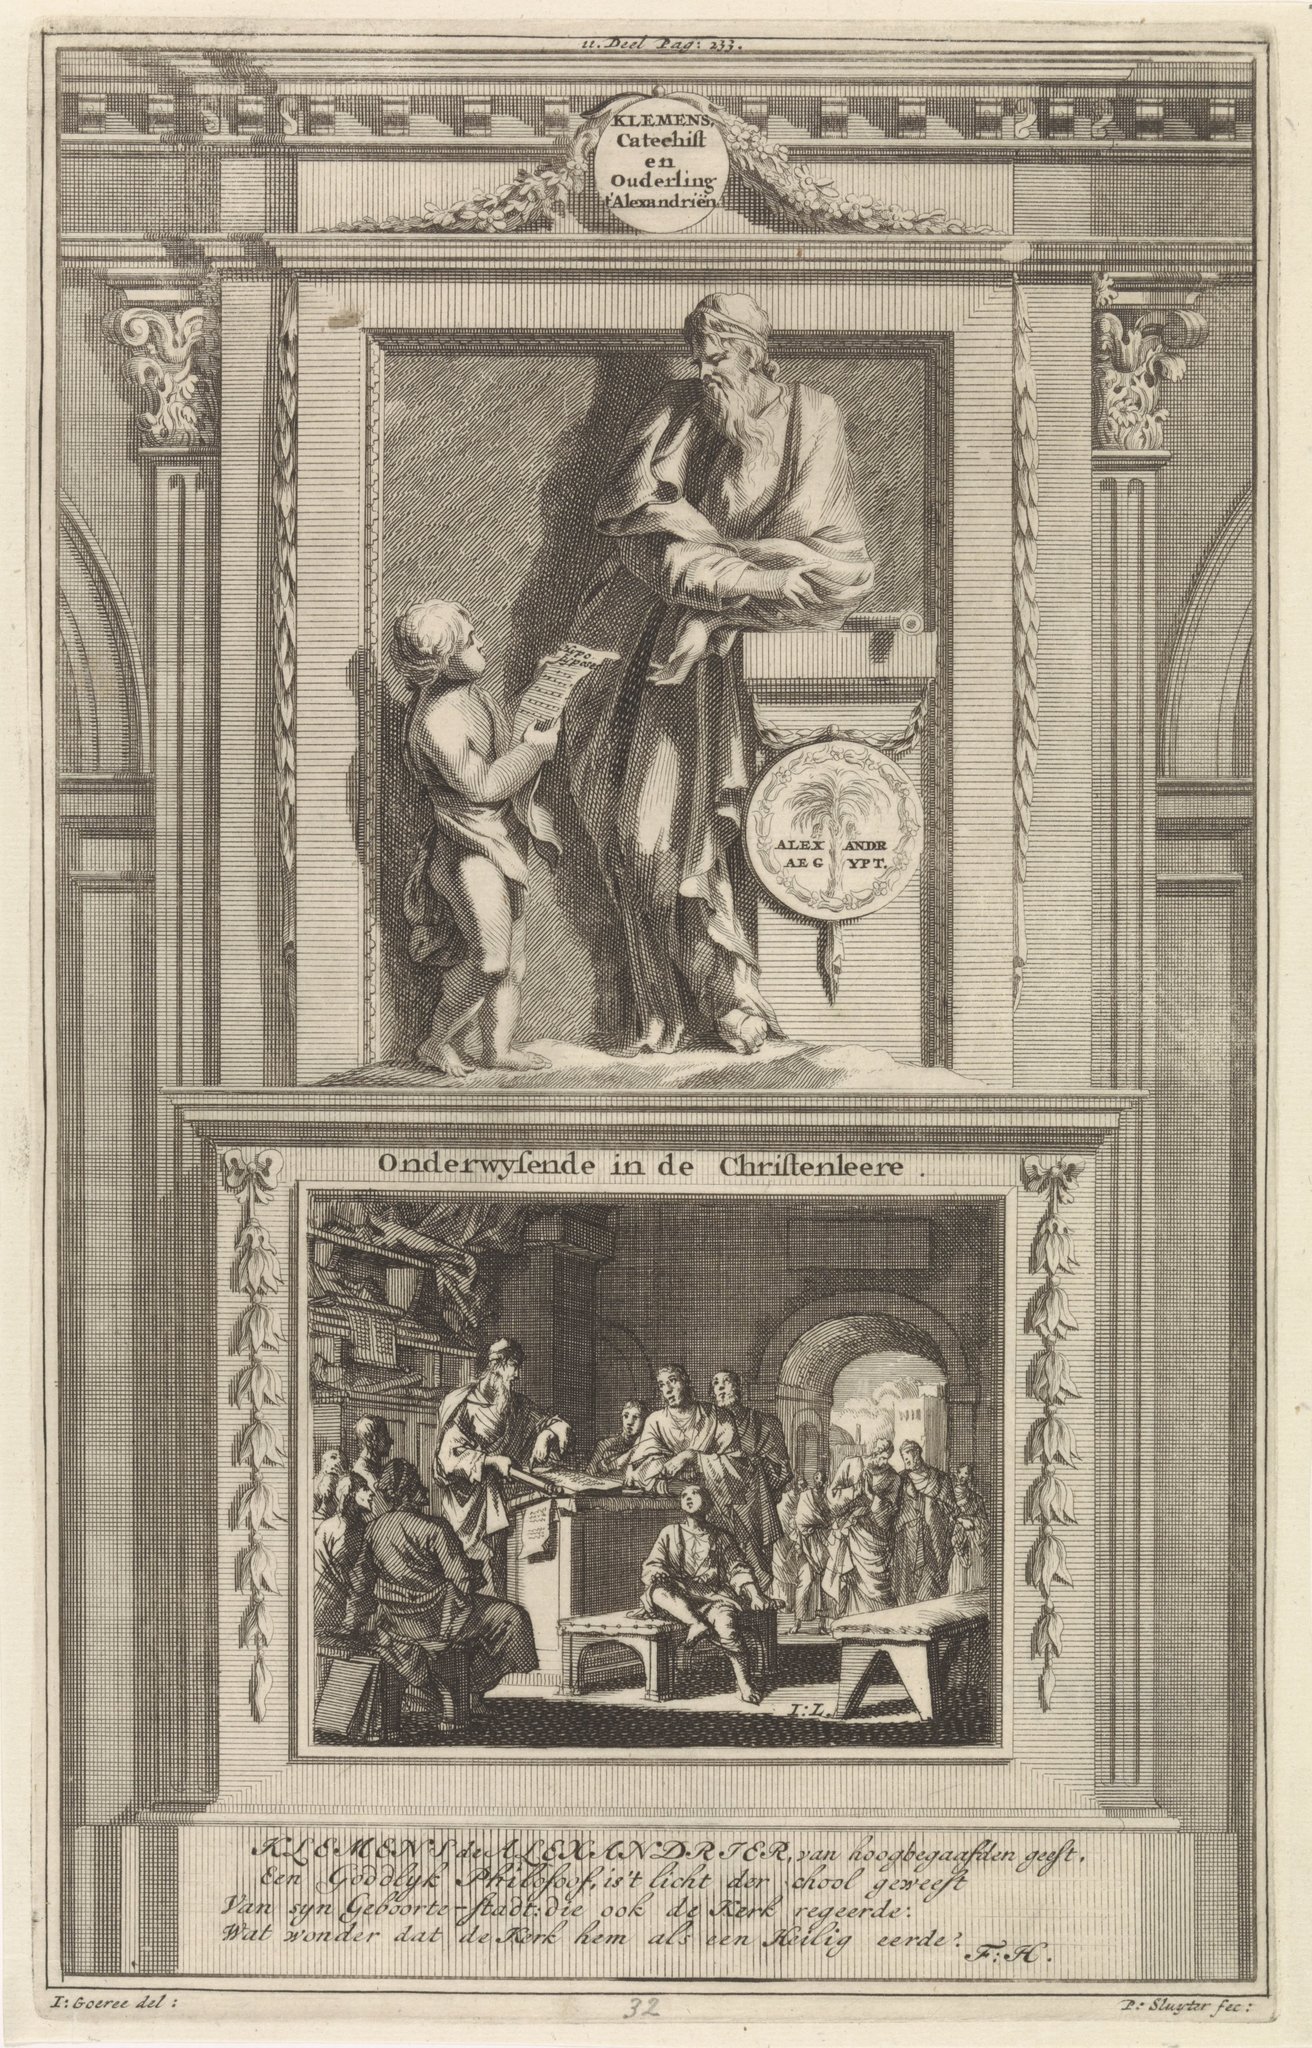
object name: book illustration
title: Klemens, Catechist en Ouderling t'Alexandriën Onderwysende in de Christenleere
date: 1698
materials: paper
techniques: engraving, etching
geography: amsterdam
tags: male saints (clemens of alexandria) - male saint writing, studying, teaching, dictating (e.g. as doctor of the church), male saints (clemens of alexandria)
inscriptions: collector's mark: Lugt 2228, number: ‘32’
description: De heilige kerkvader Clemens van Alexandrië luisterend naar een engel die hem een tekst voorleest. Clemens staat op een sokkel waar op de voorzijde zijn onderricht in de School van Alexandrië in beeld is gebracht. Prent middenboven gemerkt: II Deel Pag: 233.